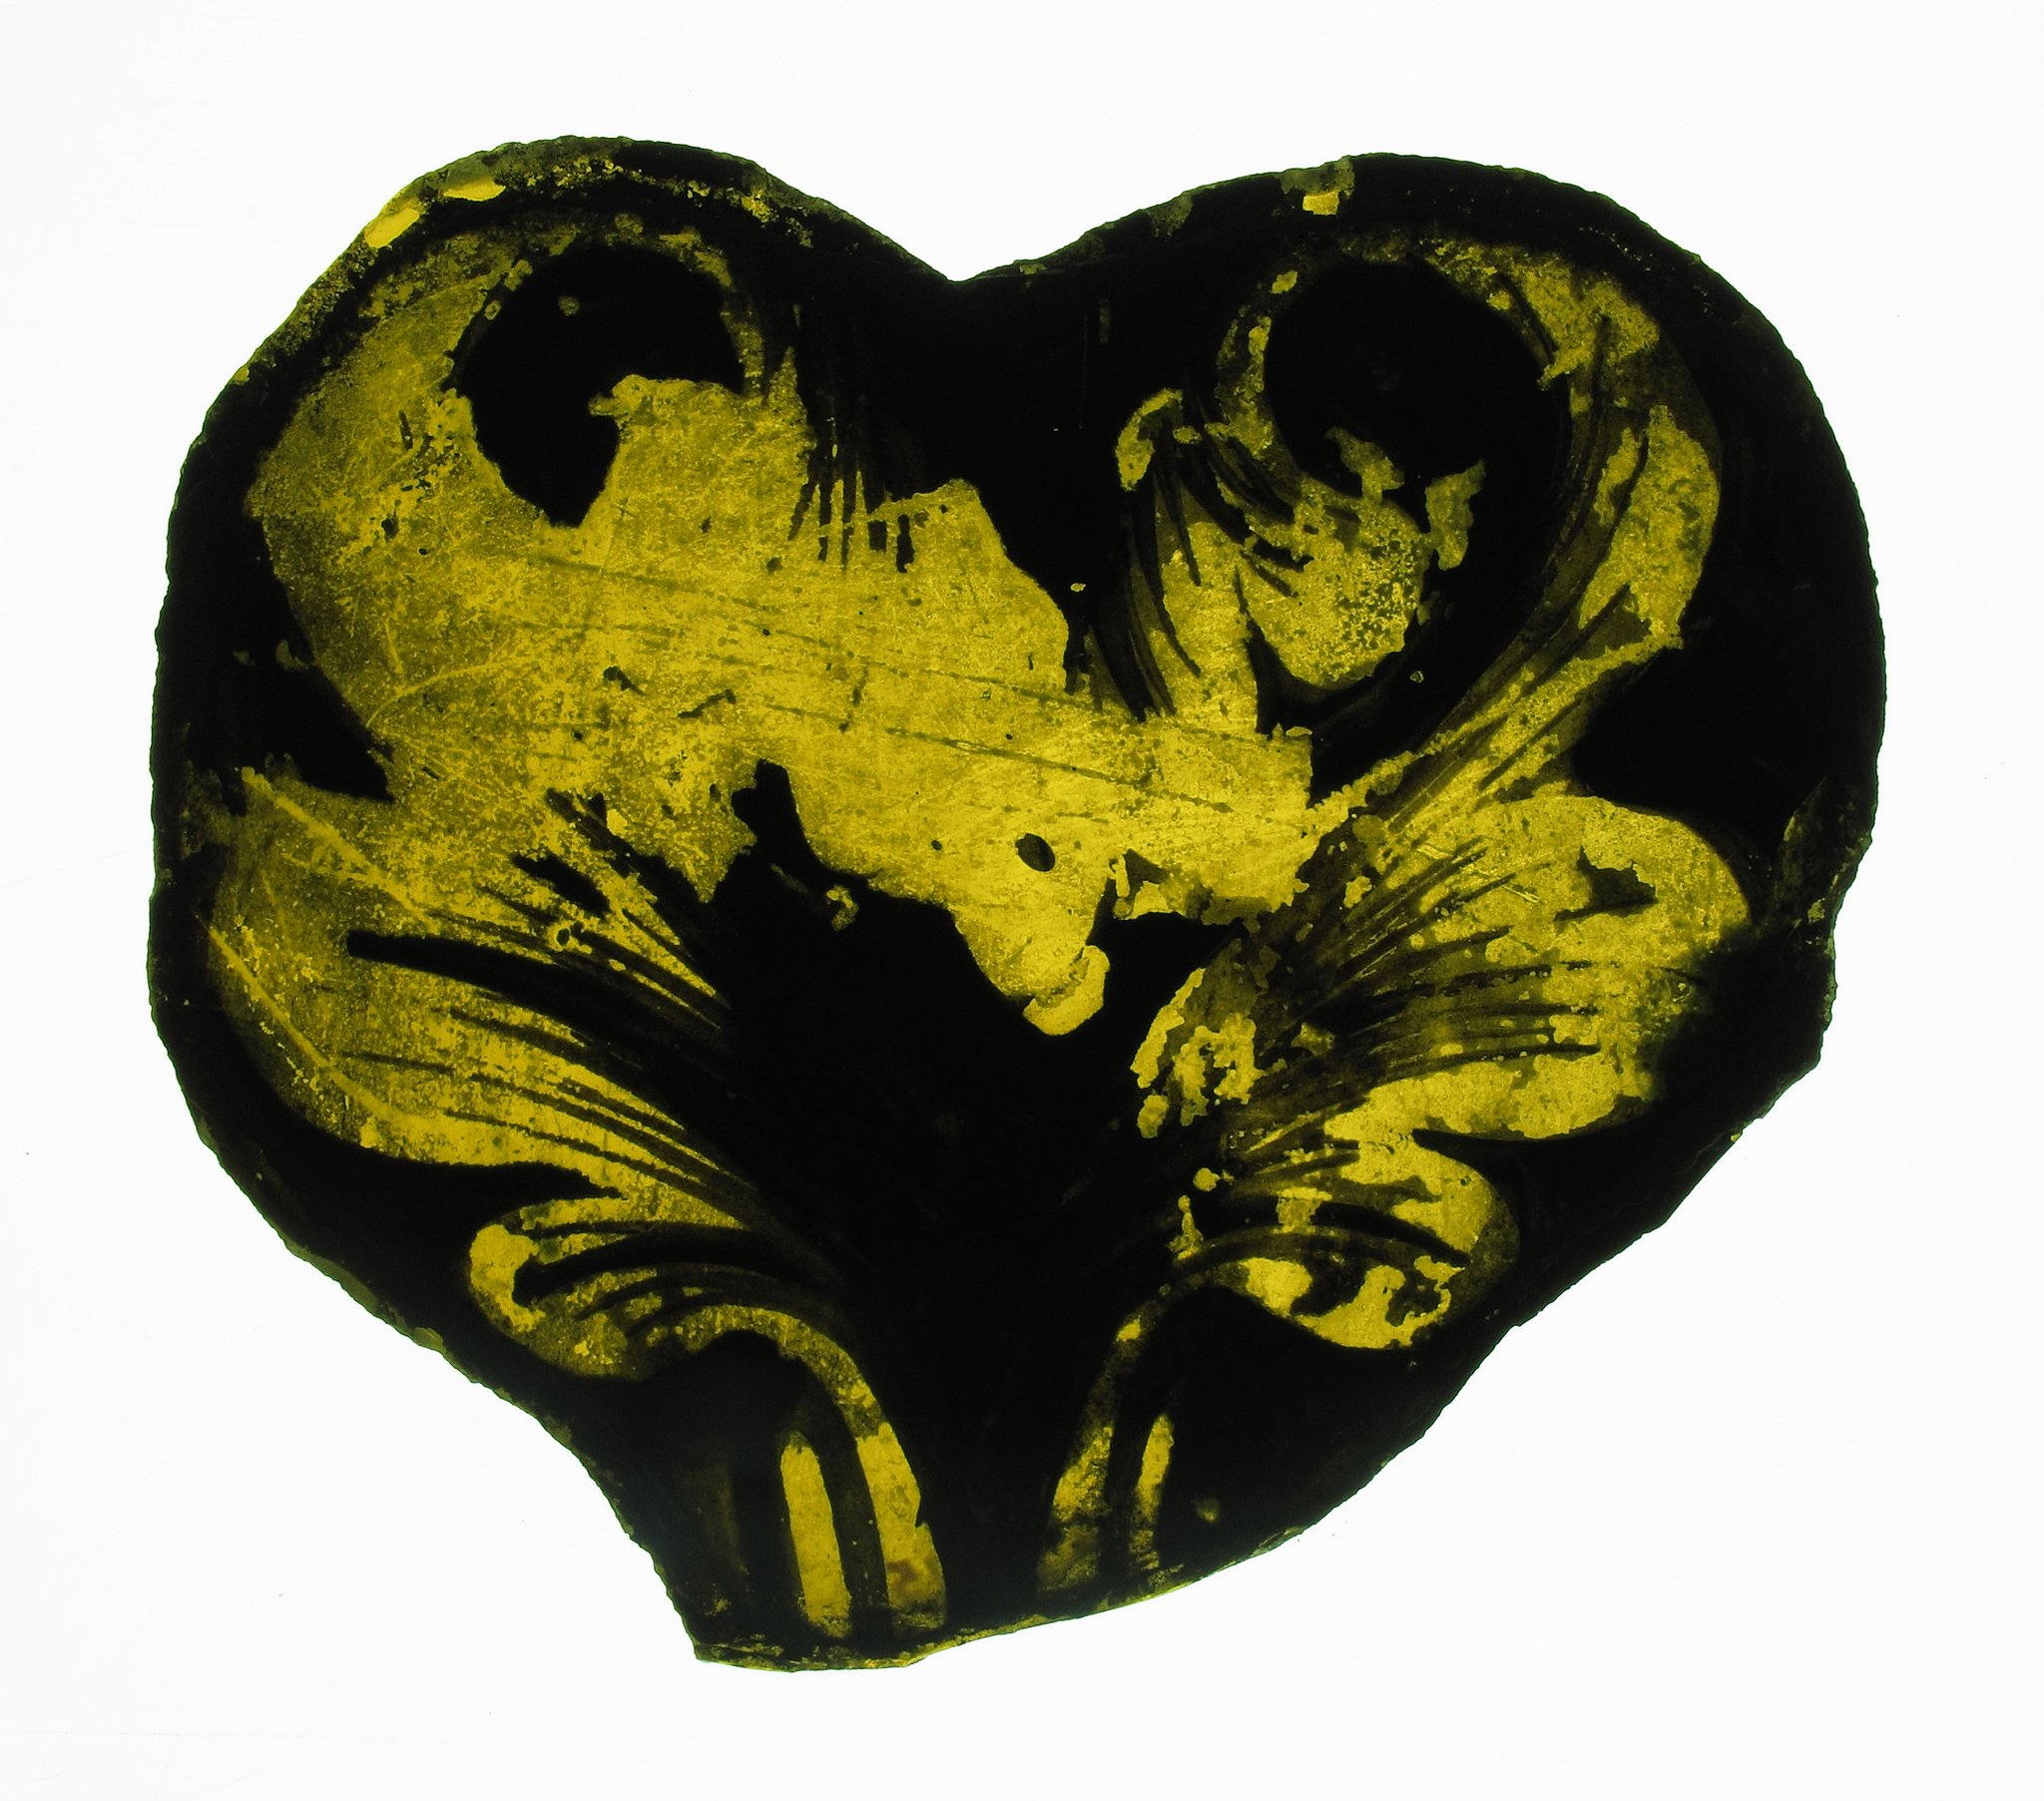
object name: fragment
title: Glass Fragment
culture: european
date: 1301-1400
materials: glass, metal